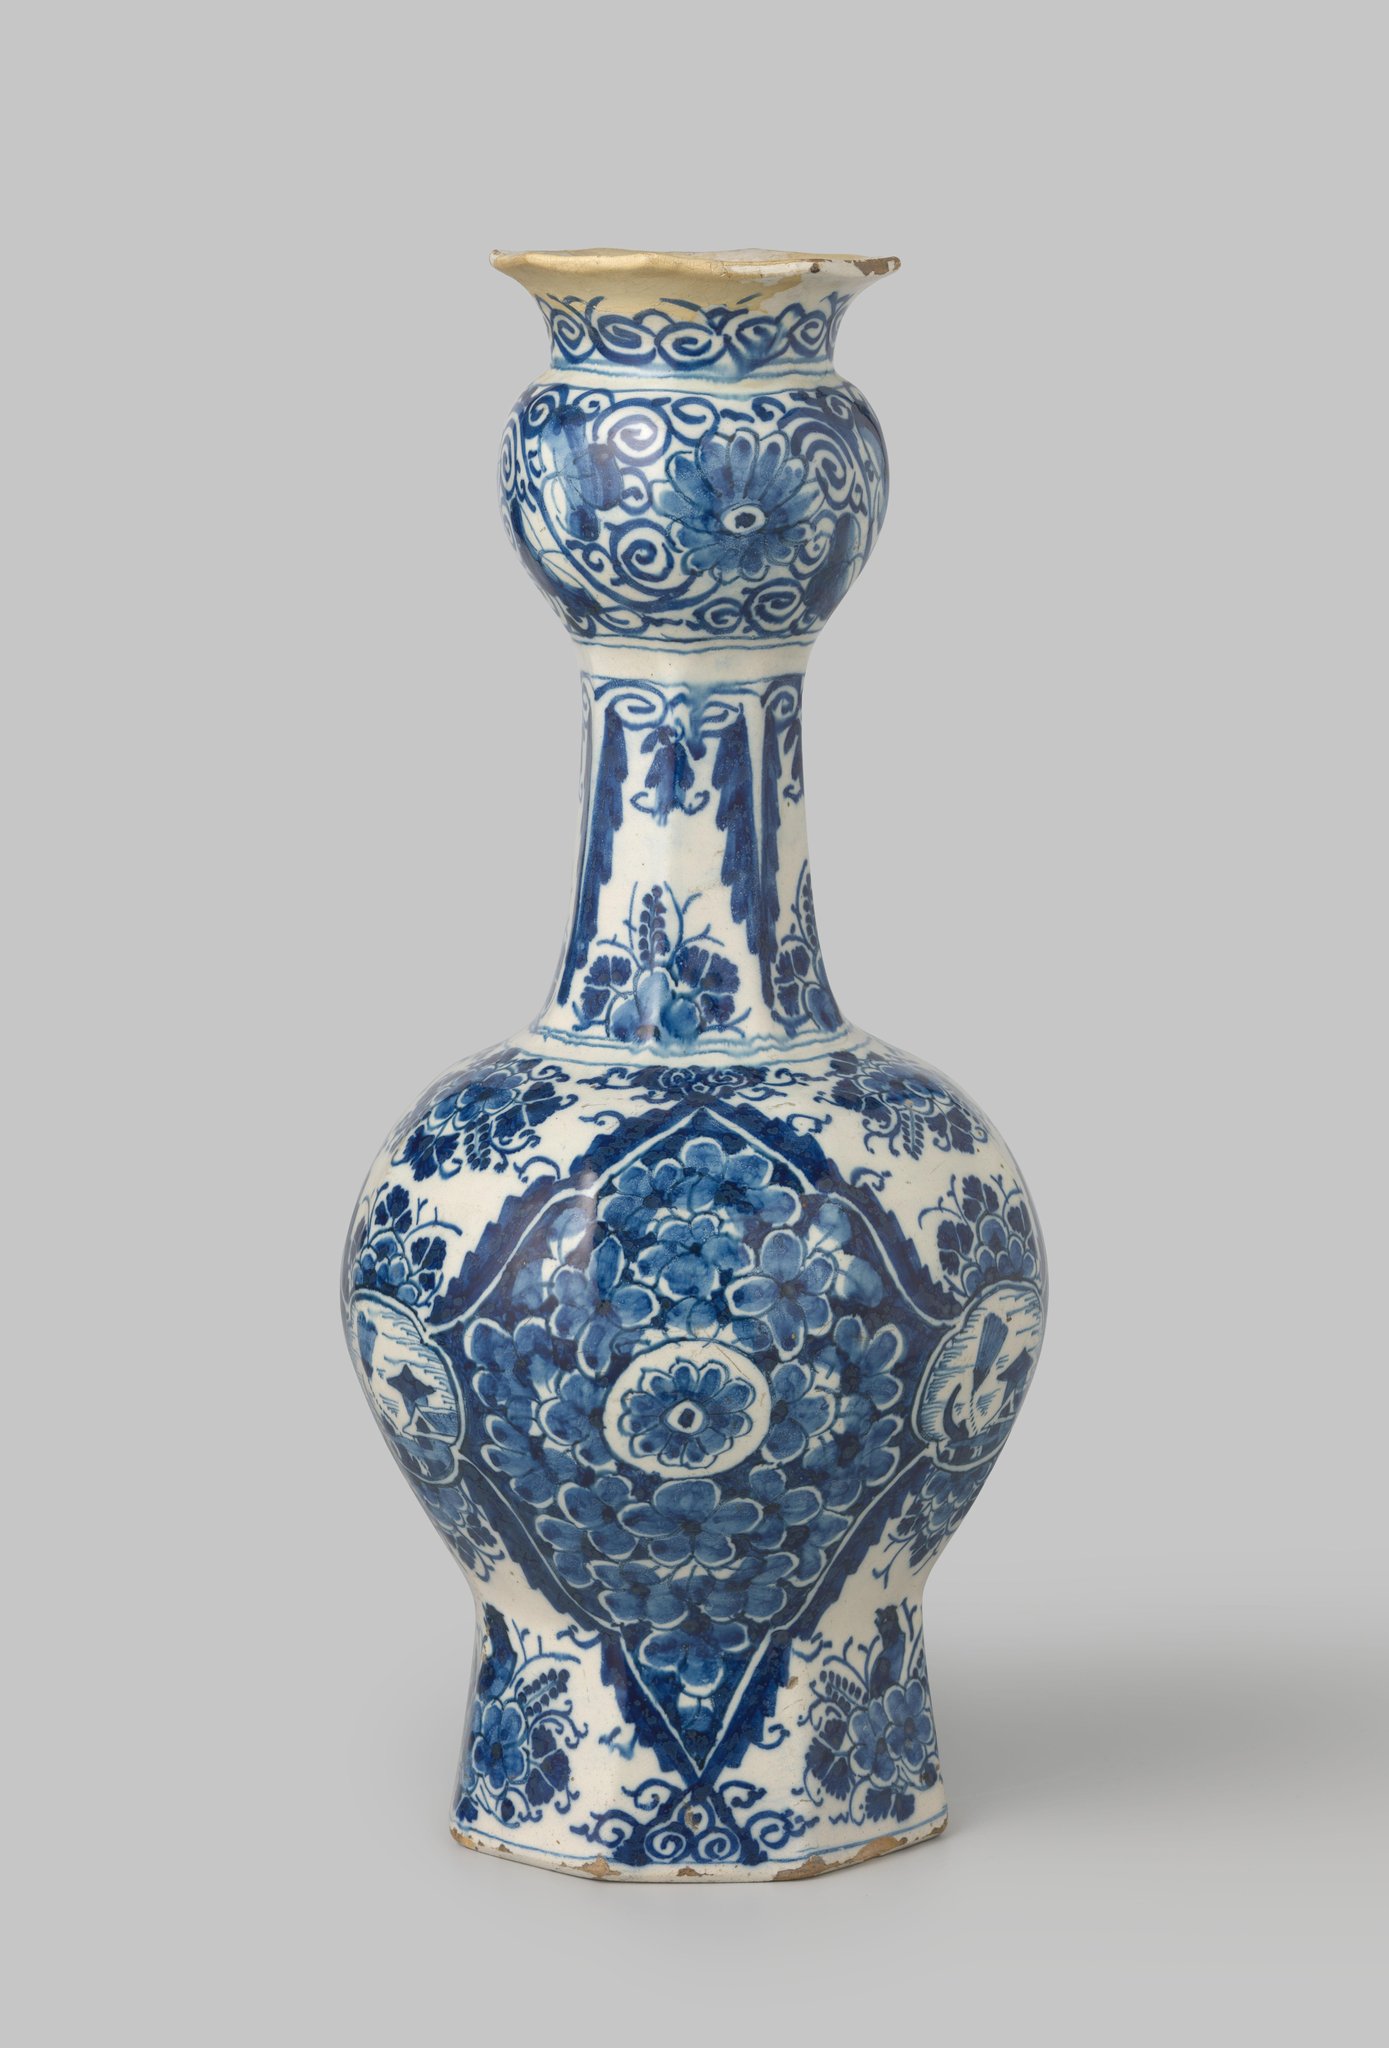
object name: vase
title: Vaas van faience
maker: Anonymous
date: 1725-1750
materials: faience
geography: delft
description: Vaas van faience. Blauw beschilderd met chinoiserie decoratie.